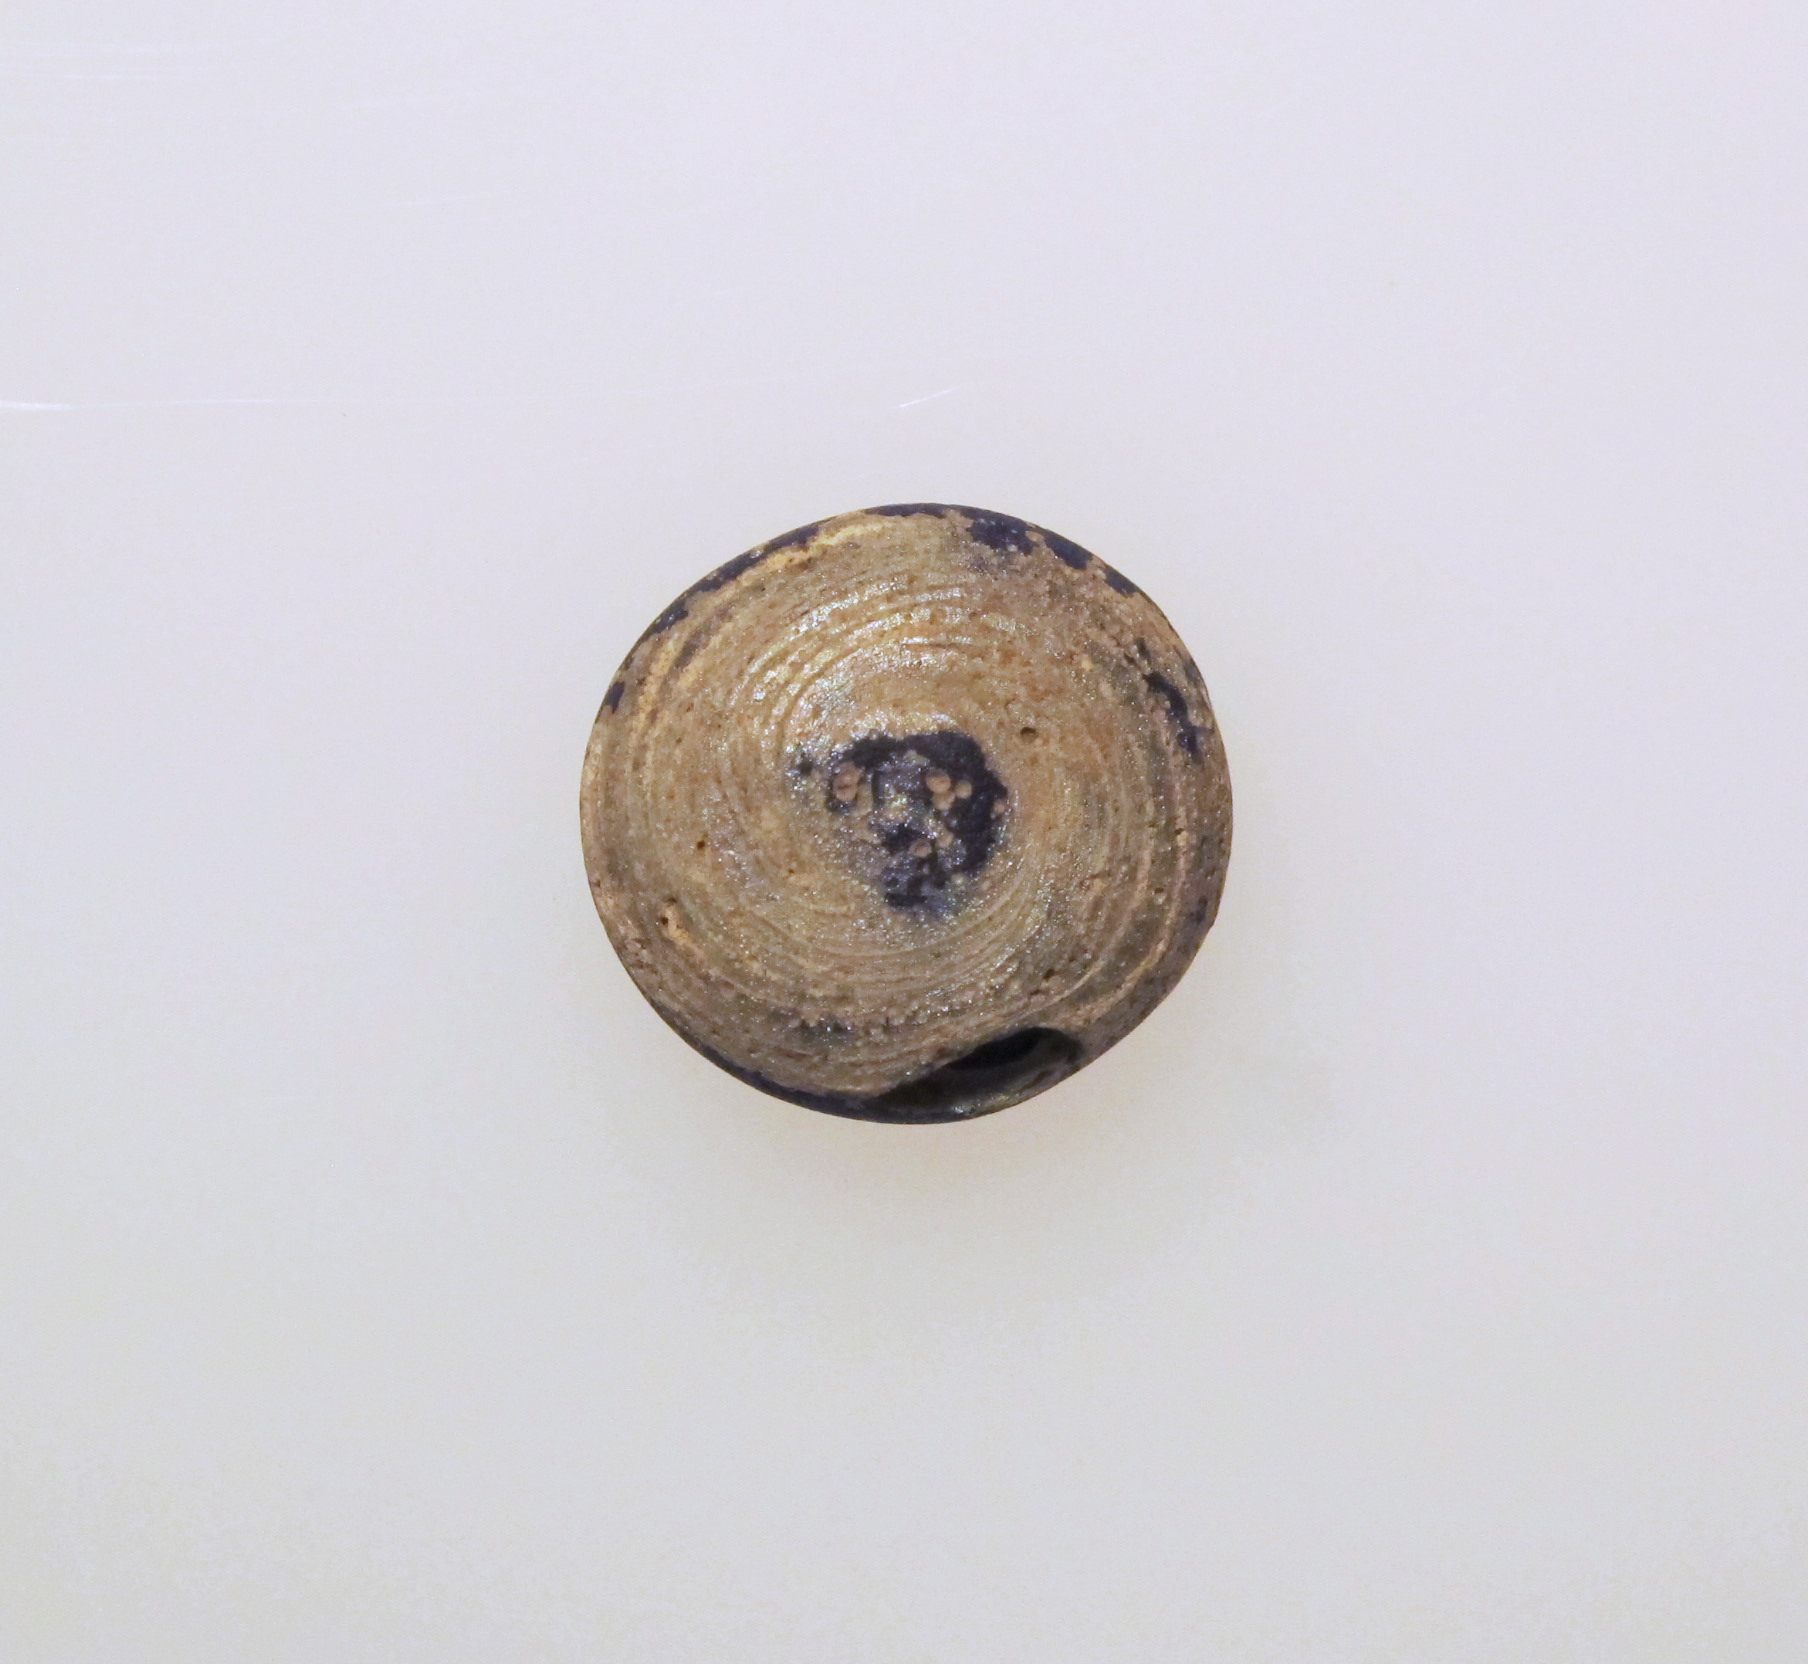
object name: pinhead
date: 7000 BCE-330 CE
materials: glass